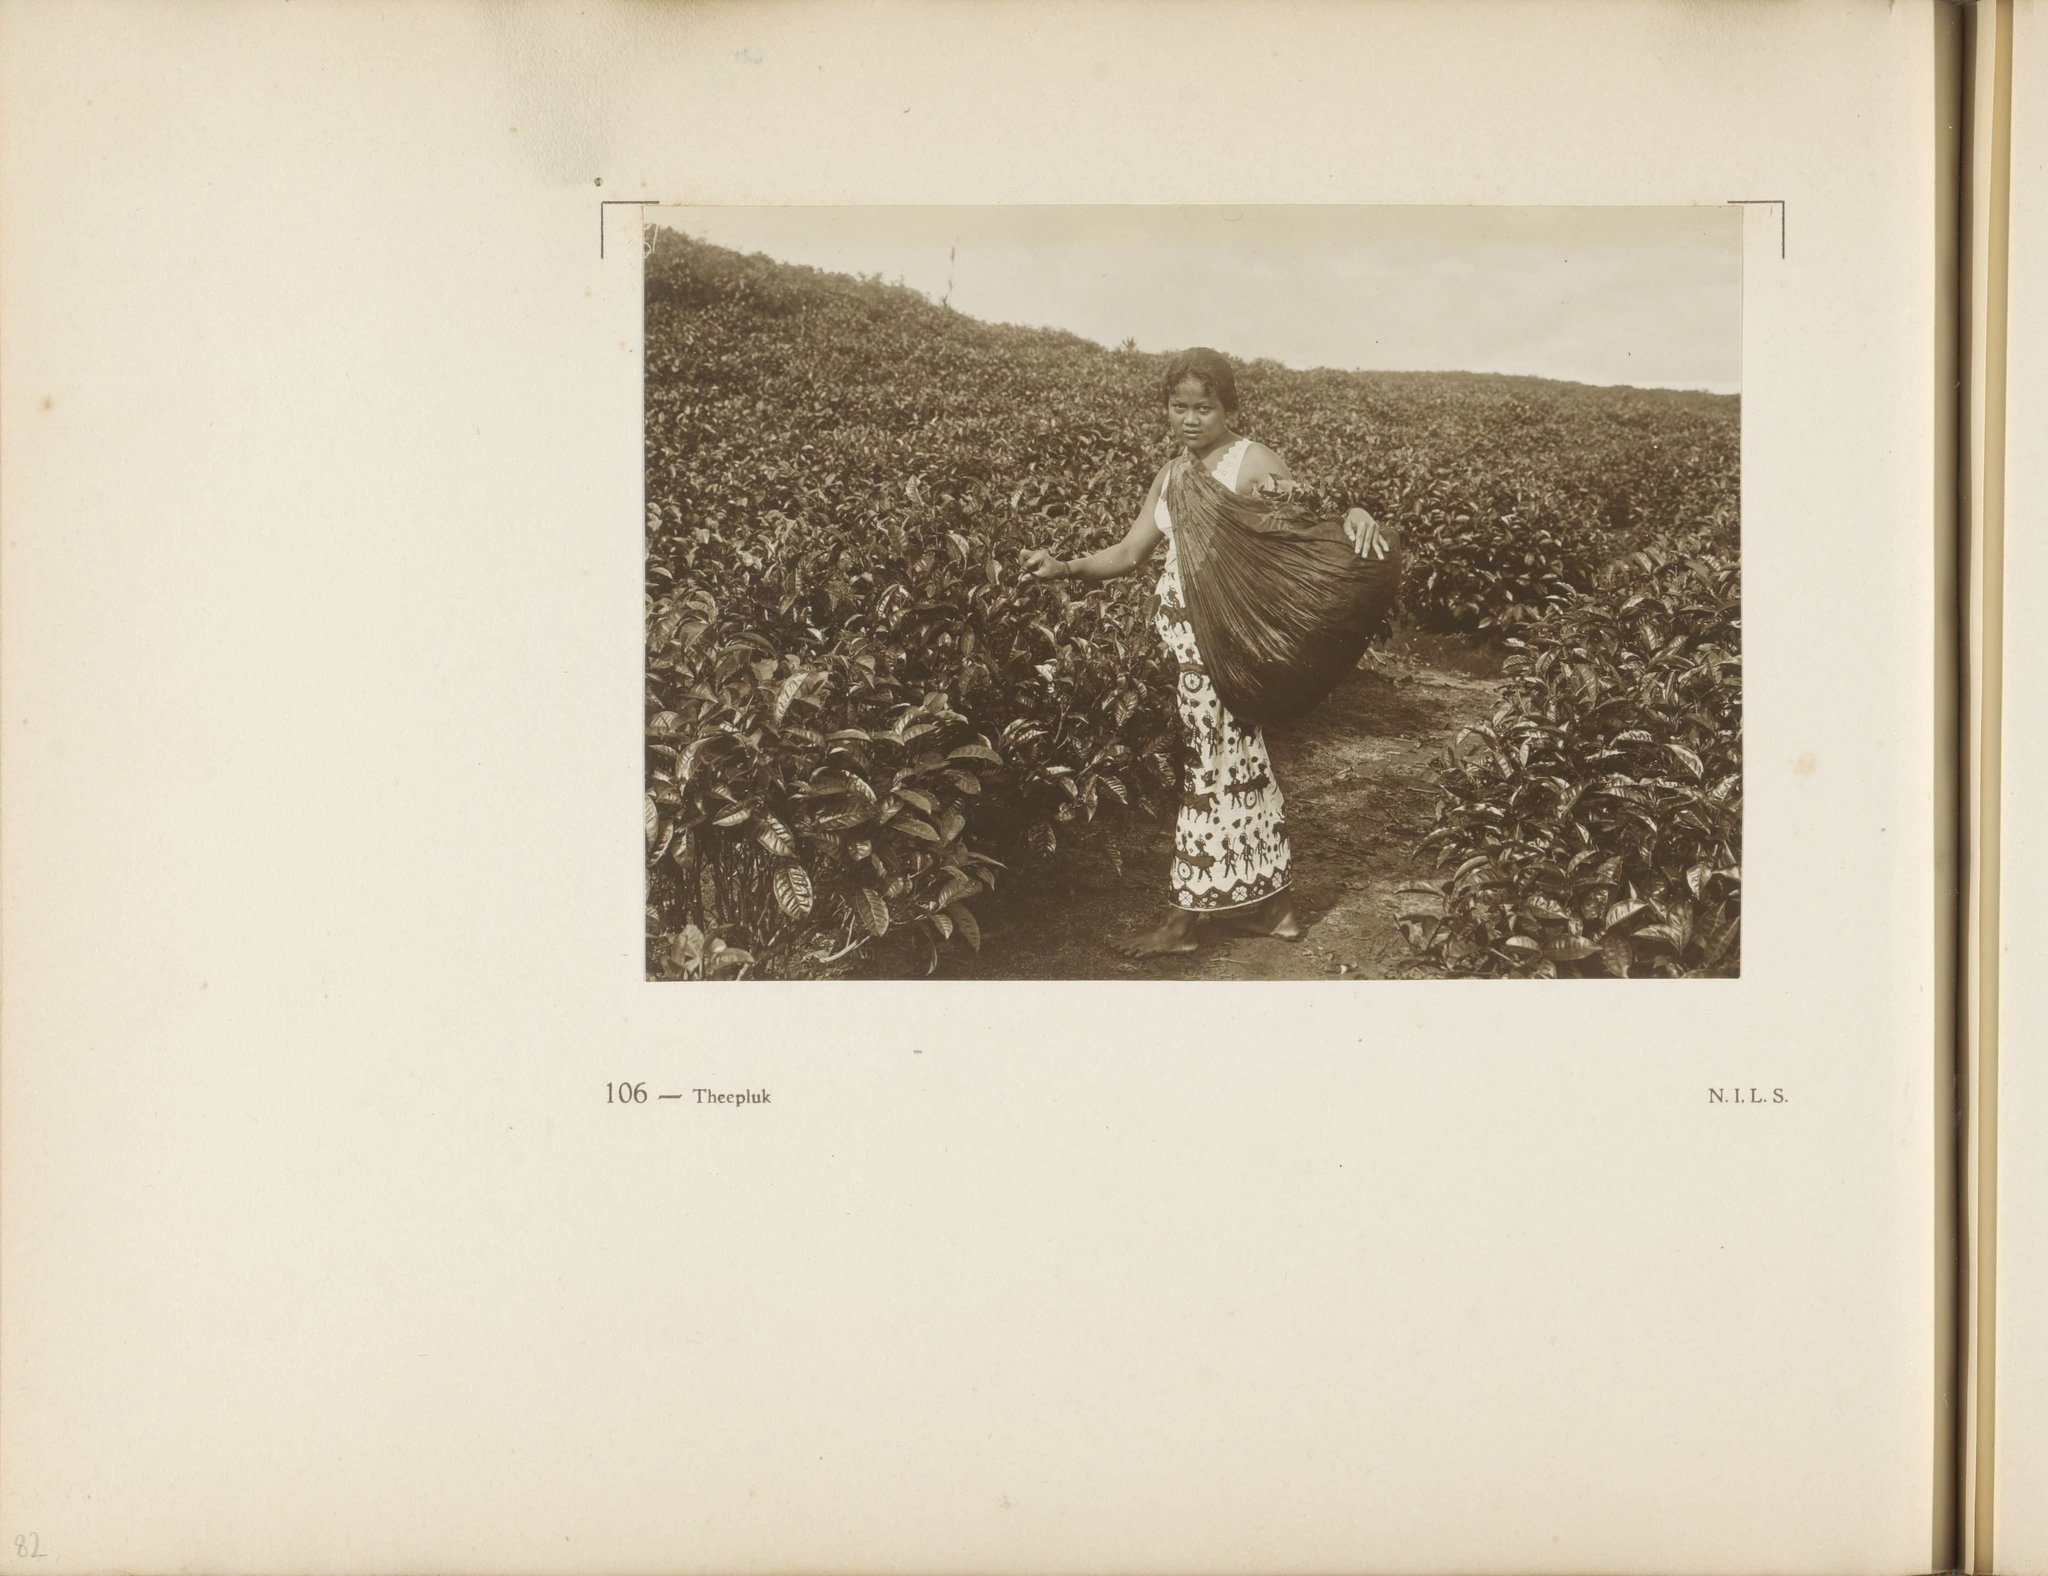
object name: photograph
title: Pagina 106 van fotoboek van de Algemeene Vereeniging van Rubberplanters ter Oostkust van Sumatra (A.V.R.O.S.)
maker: j.w. meyster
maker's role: fotograaf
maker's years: 1887-1945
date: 1924-1925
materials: paper, photographic support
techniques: printing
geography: sumatra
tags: plantation, (non-fruit) products of plants or trees: rubber, tea (leaves), reaping, picking, mowing ~ harvest, sumatra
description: Boekpagina met een foto van een theeplukster aan het werk op Sumatra (Nederlandsch-Indisch Land Syndicaat). Onderdeel van een fotoboek van de Algemeene Vereeniging van Rubberplanters ter Oostkust van Sumatra (A.V.R.O.S.).